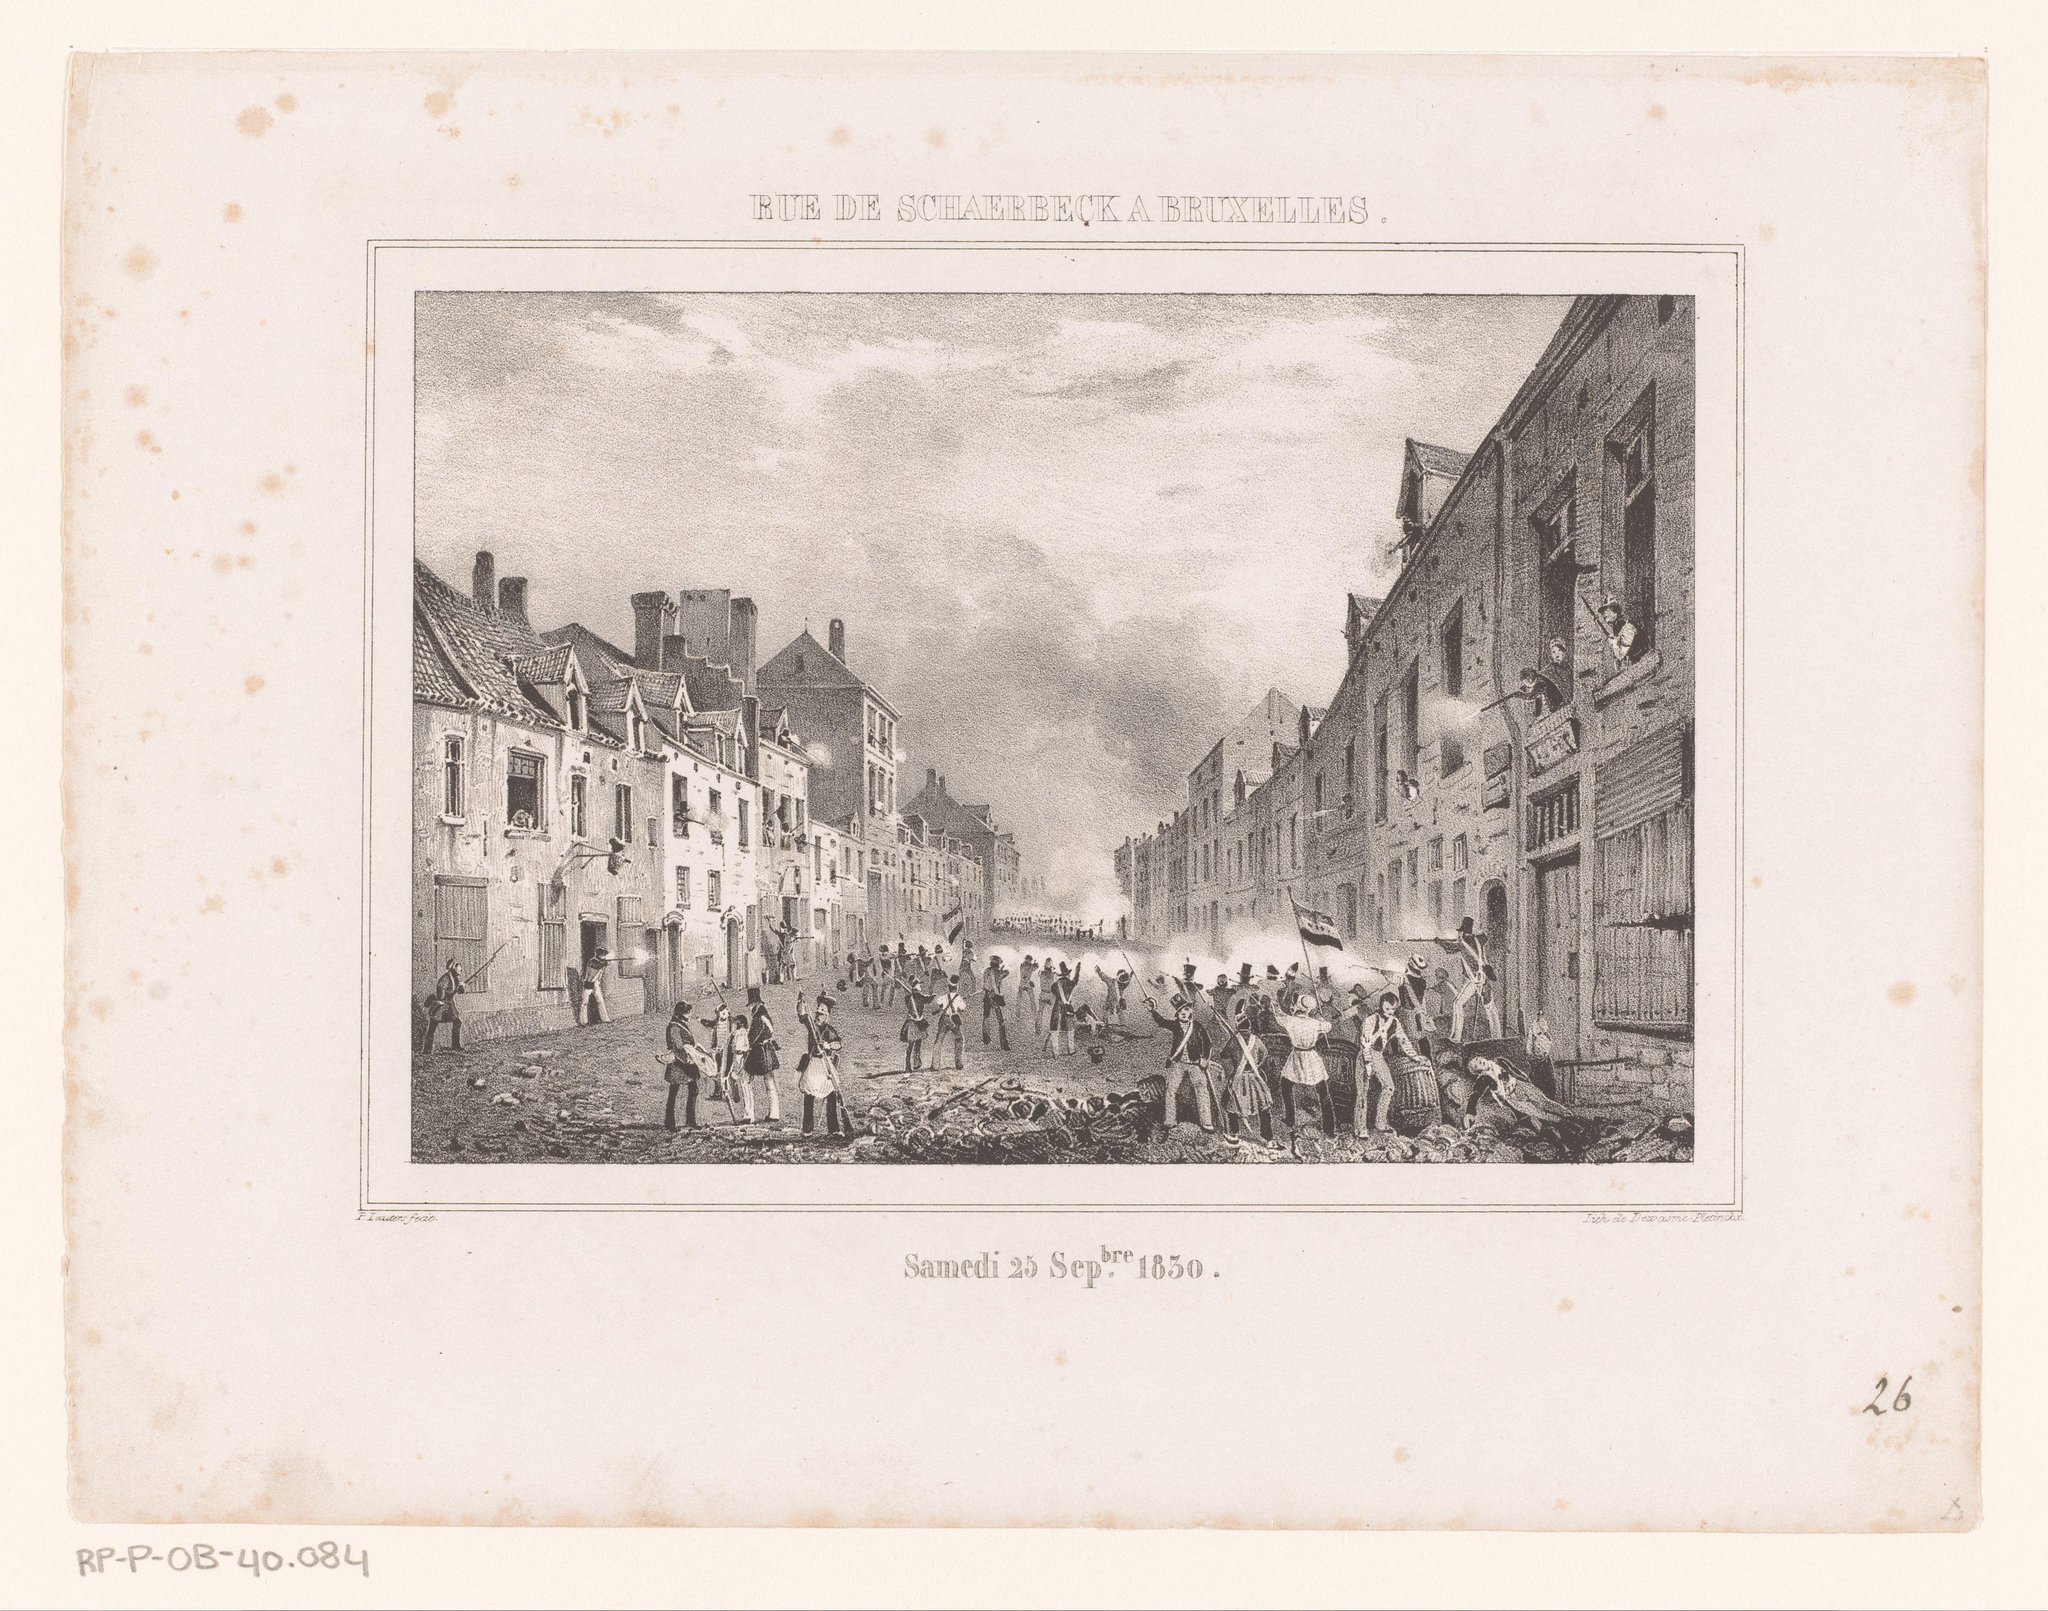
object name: print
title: Evénemens de Bruxelles, Anvers (...)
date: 1830-1831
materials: paper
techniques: lithograph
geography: brussels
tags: warfare; military affairs, revolution, revolt, brussels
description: Prent maakt deel uit van een serie met prenten over de gebeurtenissen tijdens de Belgische Revolutie in Brussel, Antwerpen en andere steden in de periode 25 augustus 1830 tot 27 maart 1831.